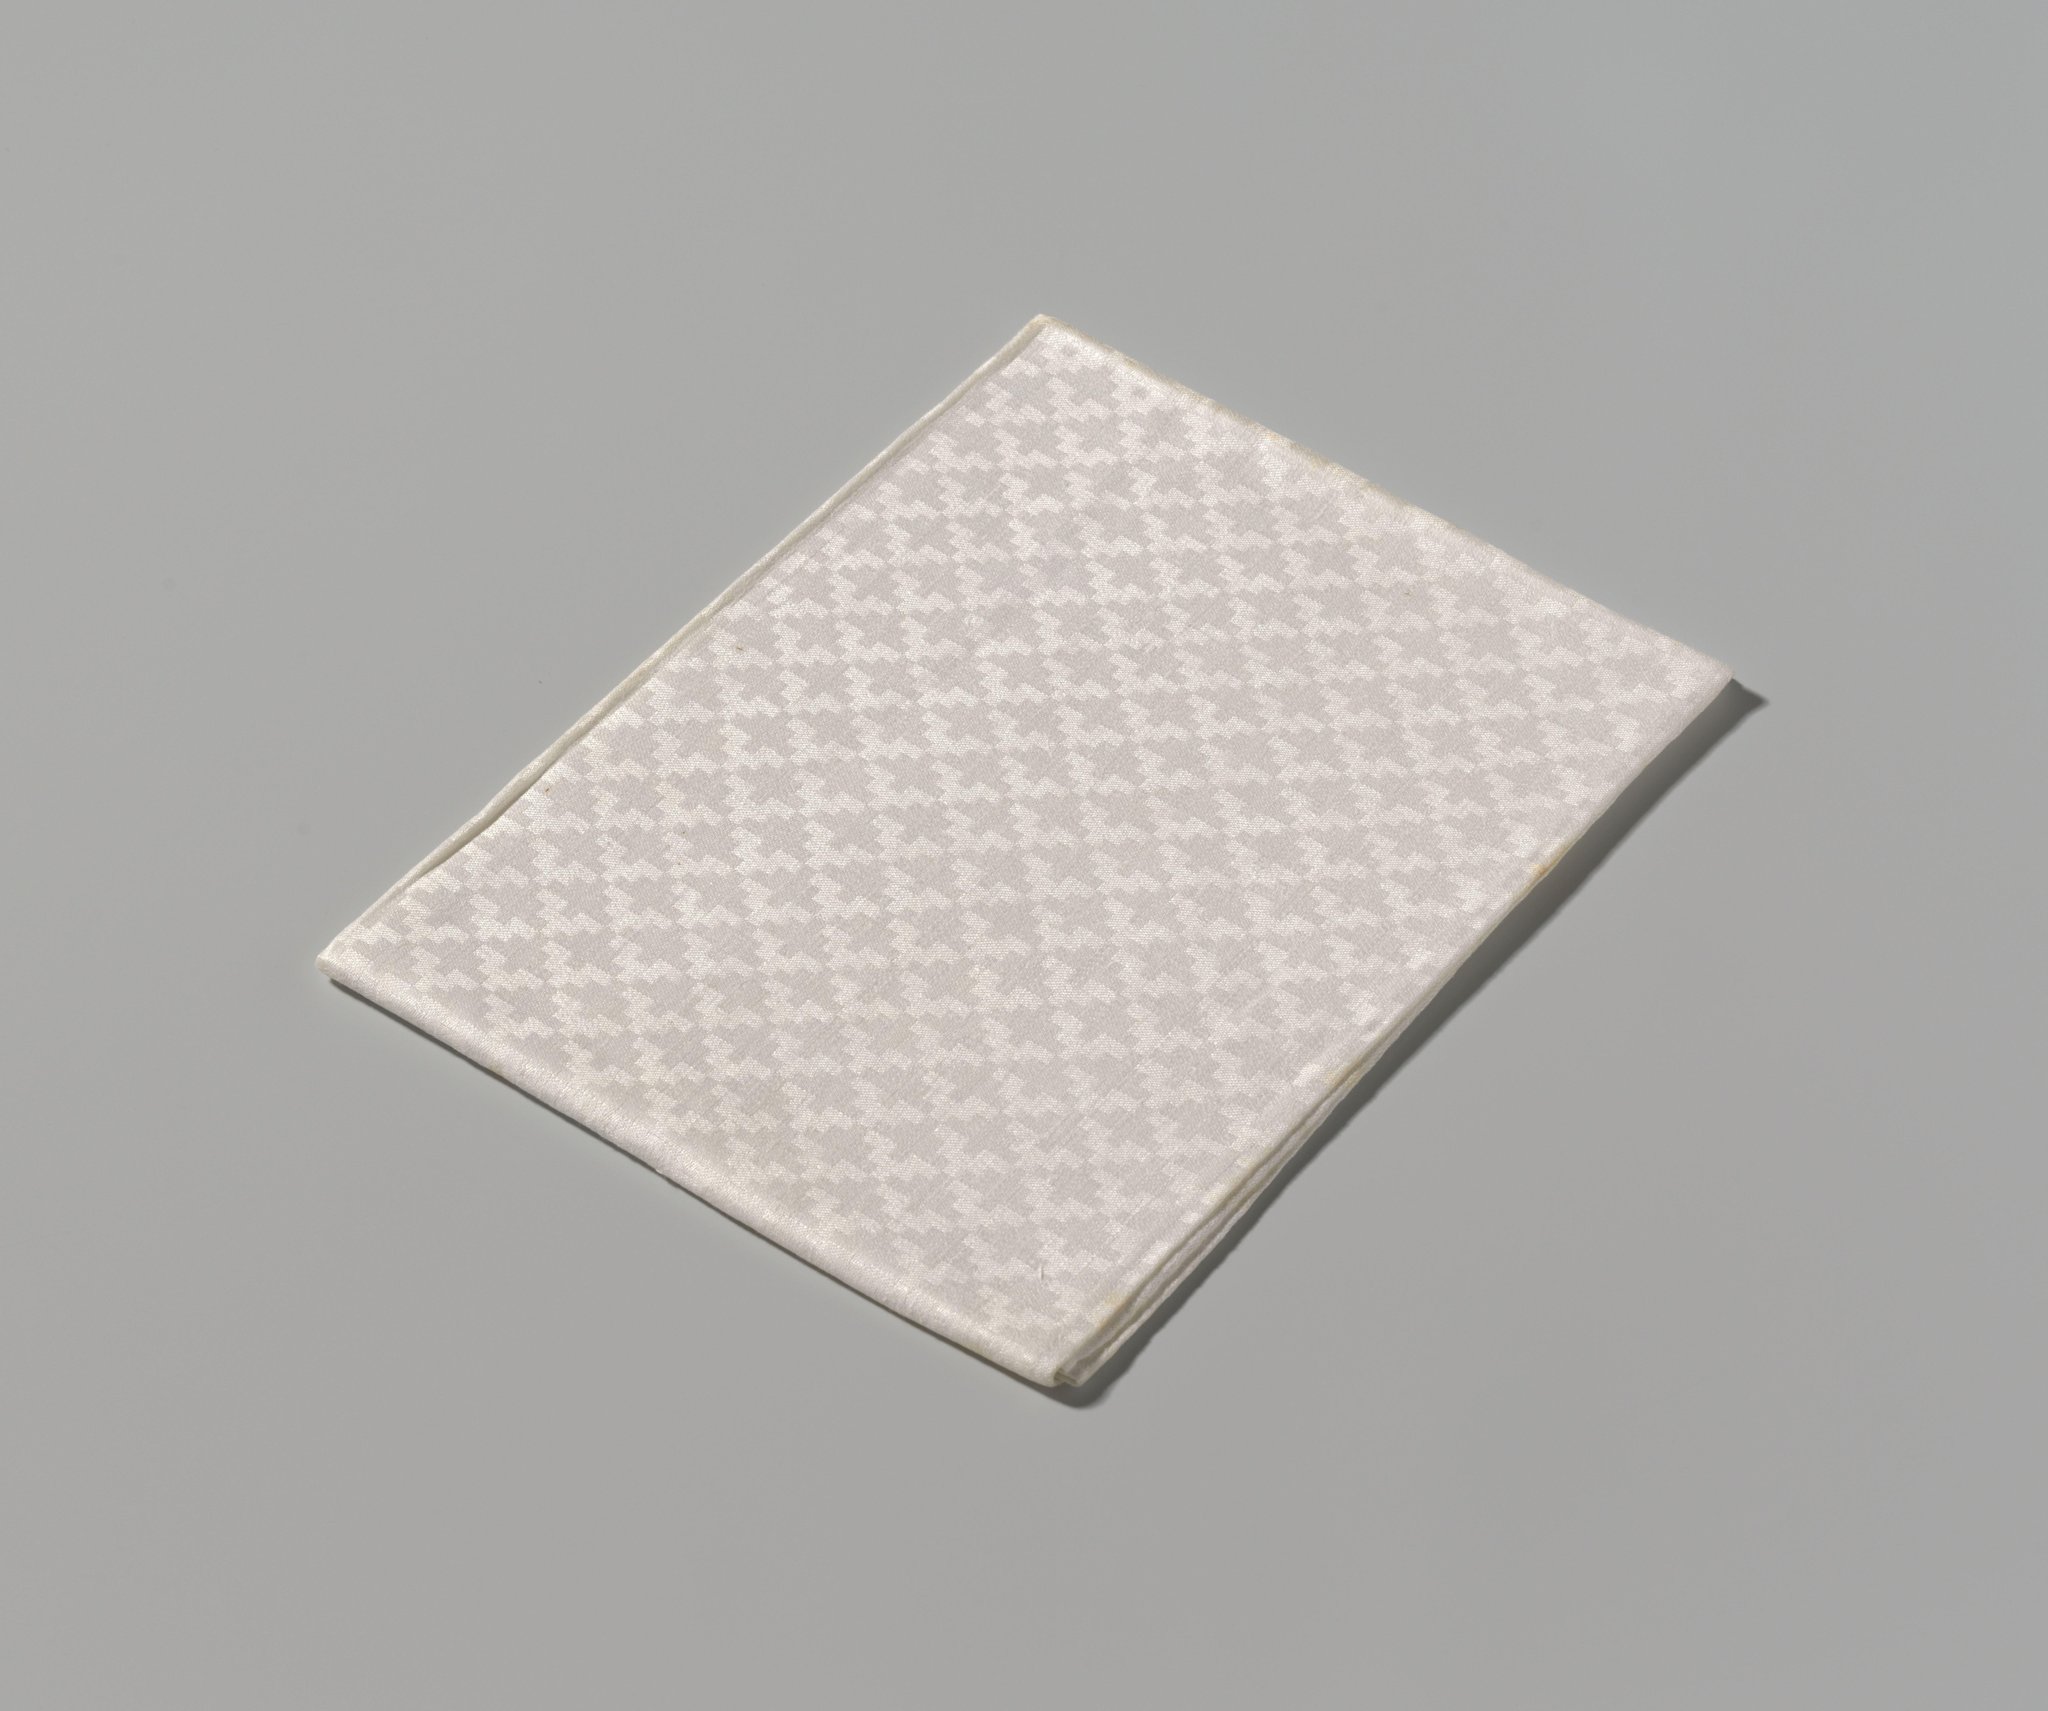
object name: napkin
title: Servet van linnen met pellenpatroon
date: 1775-1816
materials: linen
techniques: peeled fabric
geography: netherlands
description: wit linnen servet met een pellen patroon en randen rondom, merk WS 72 WH 2oonl